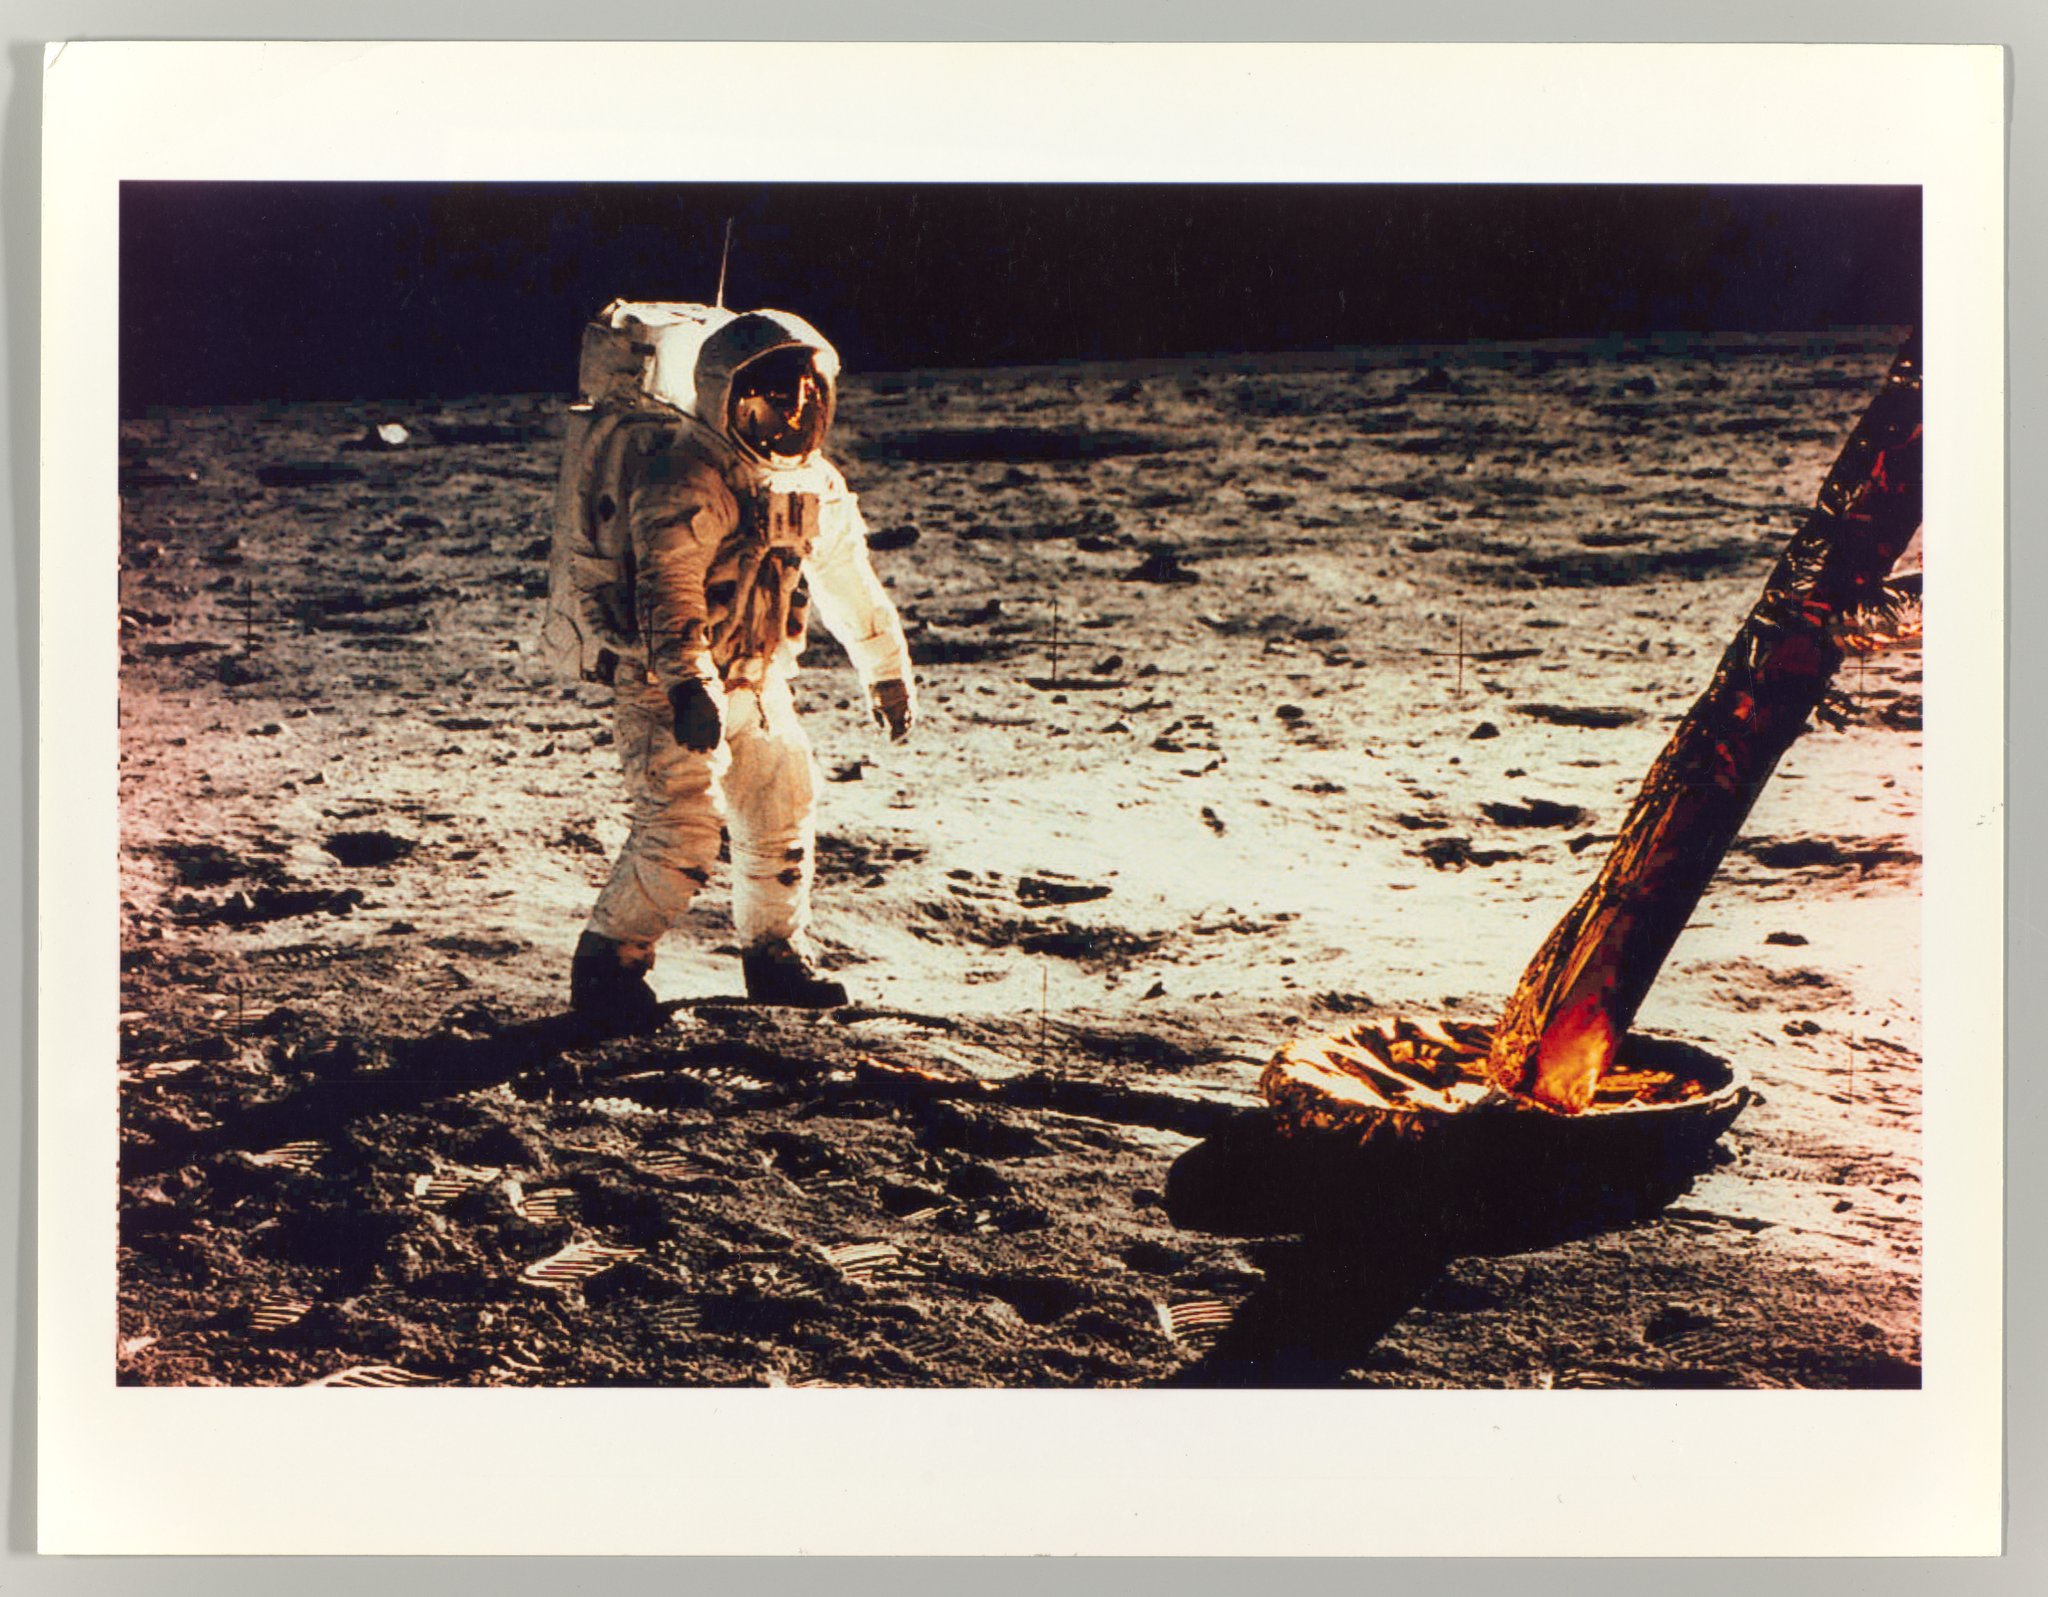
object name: photograph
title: Buzz Aldrin Walking on the Surface of the Moon Near a Leg of the Lunar Module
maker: neil armstrong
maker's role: artist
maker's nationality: american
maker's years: 1930-2012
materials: dye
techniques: transfer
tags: men,moon,astronomy